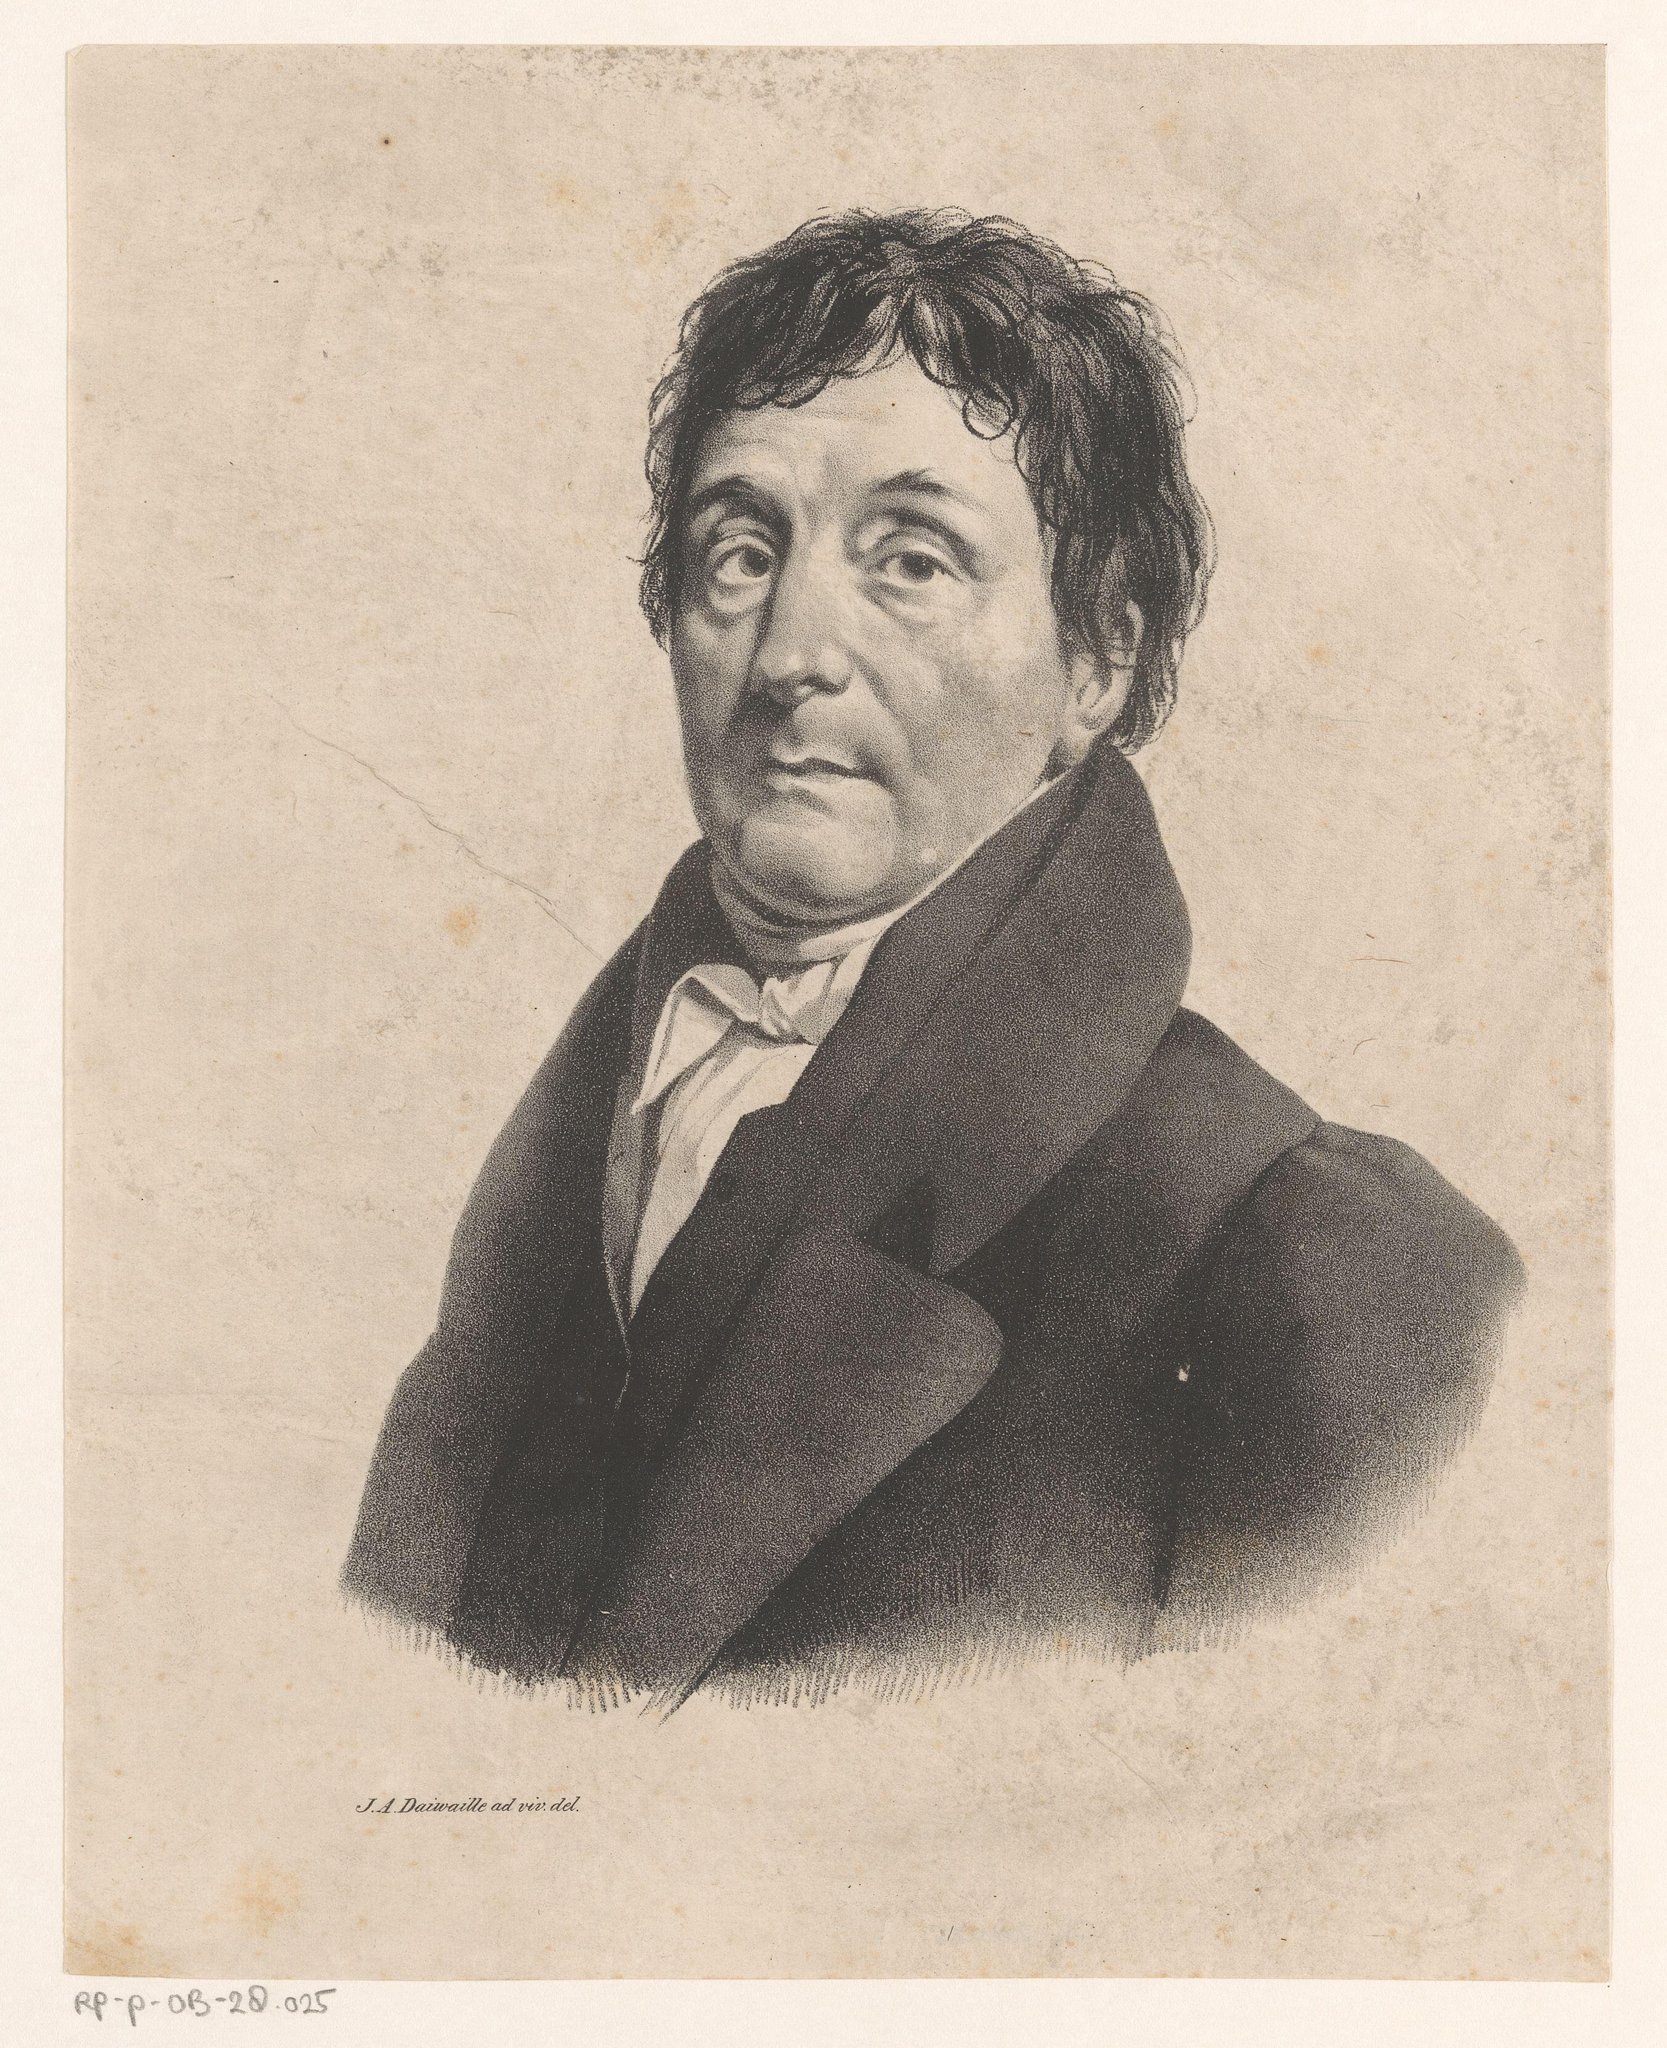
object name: print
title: Portret van Jacobus Koning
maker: jean augustin daiwaille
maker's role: draughtsman, print maker, printer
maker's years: 1786-1850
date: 1809-1850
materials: paper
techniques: lithograph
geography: amsterdam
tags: jacobus koning, historical persons (+ head (and shoulders) (portrait))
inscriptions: collector's mark: Lugt 2228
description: De geportretteerde draagt een donkere jas en een witte gestrikte das.